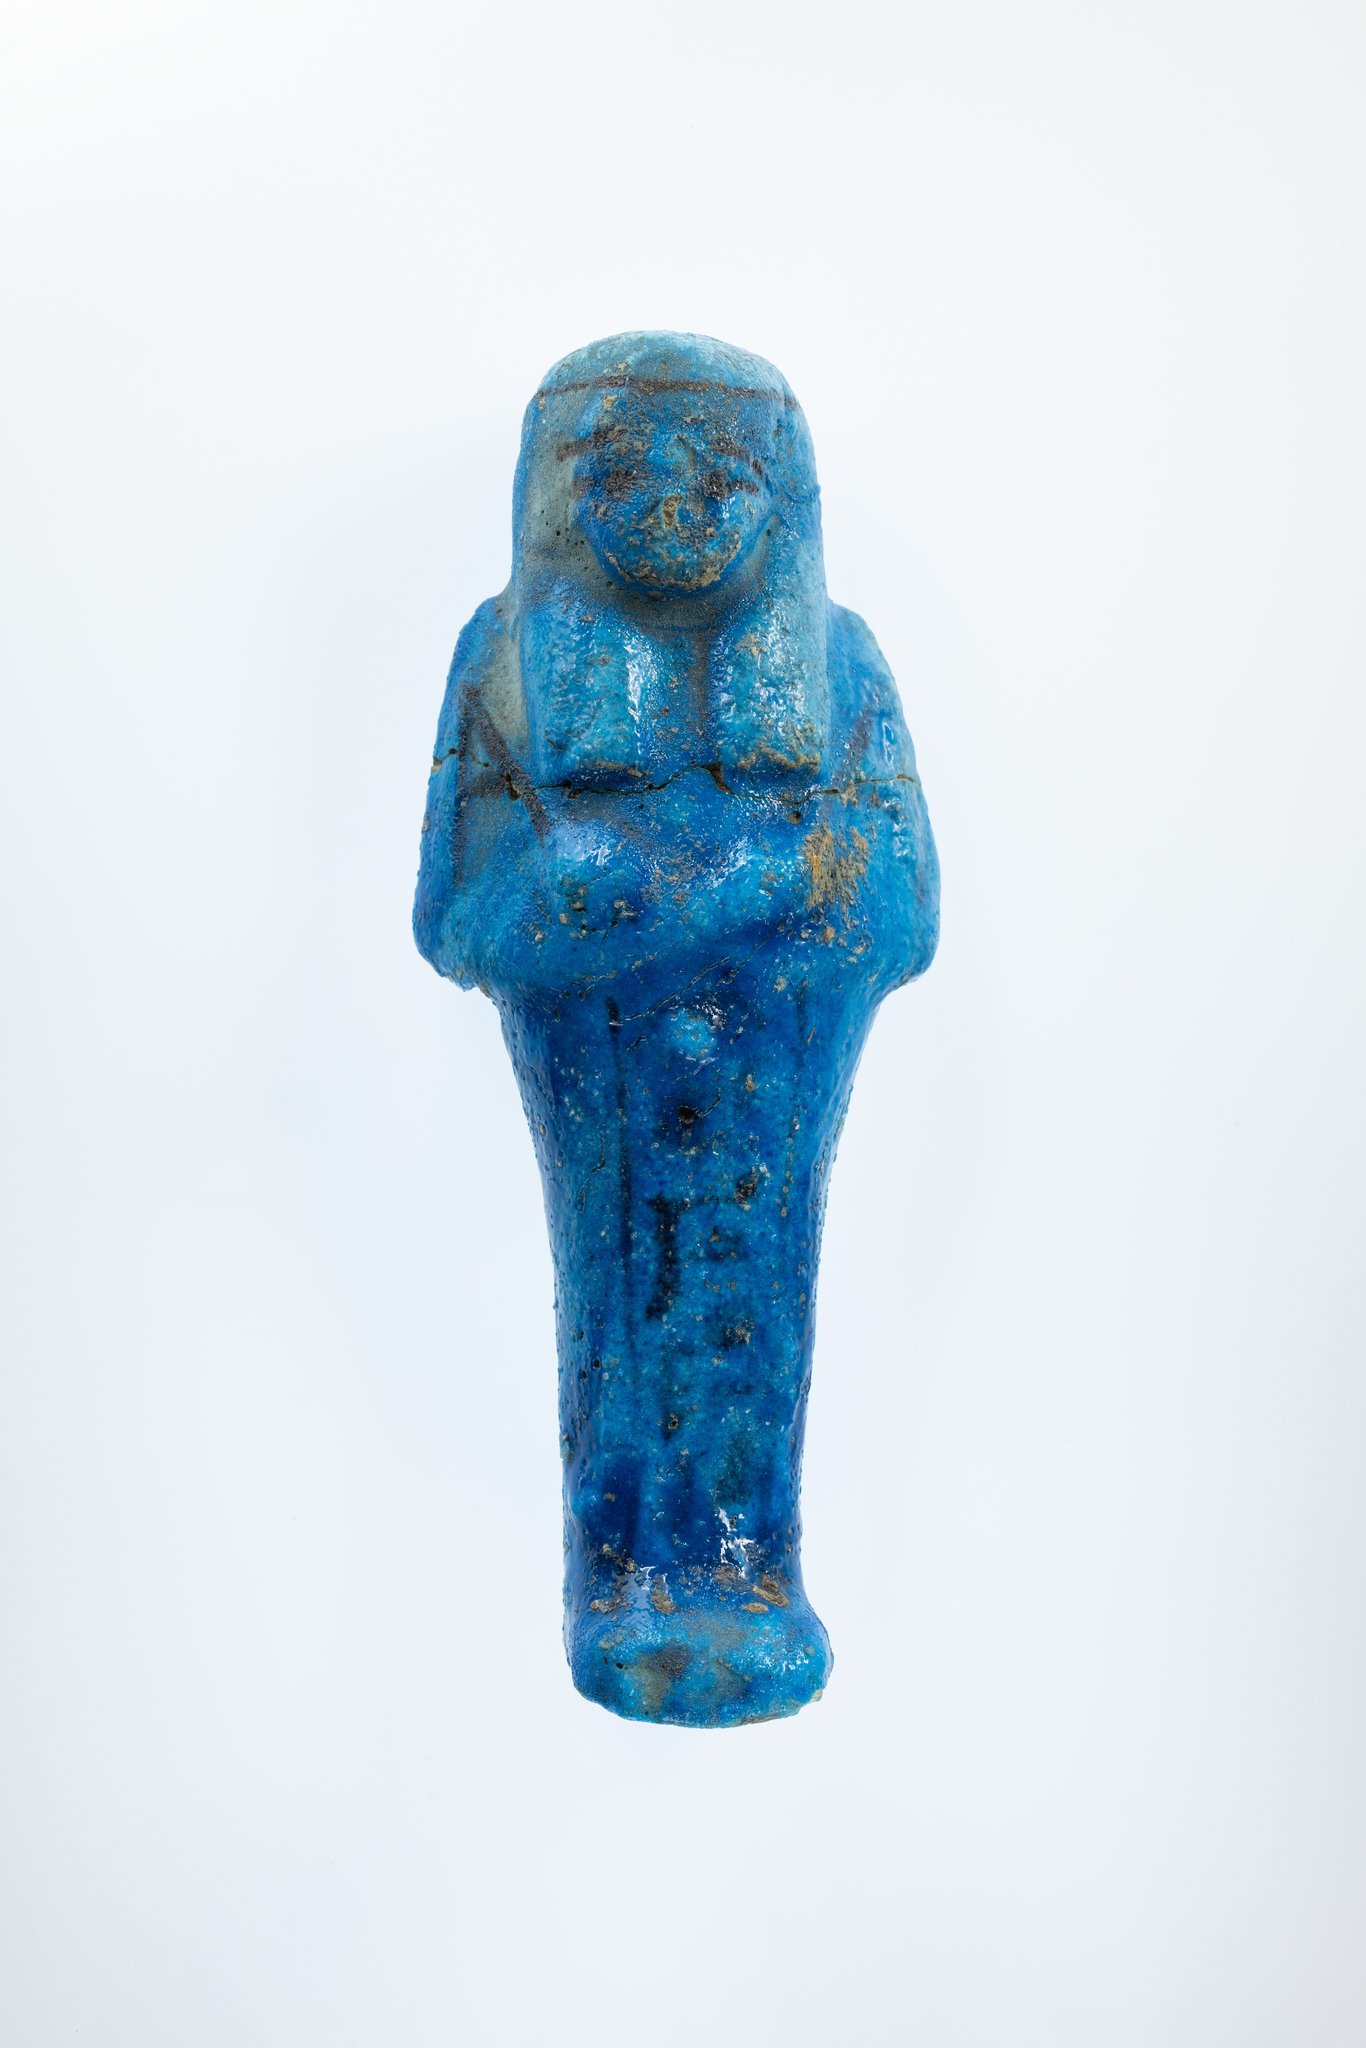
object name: shabti, djedkhonsuefankh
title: Shabti of Djedkhonsuefankh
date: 1070-945 BCE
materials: faience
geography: egypt